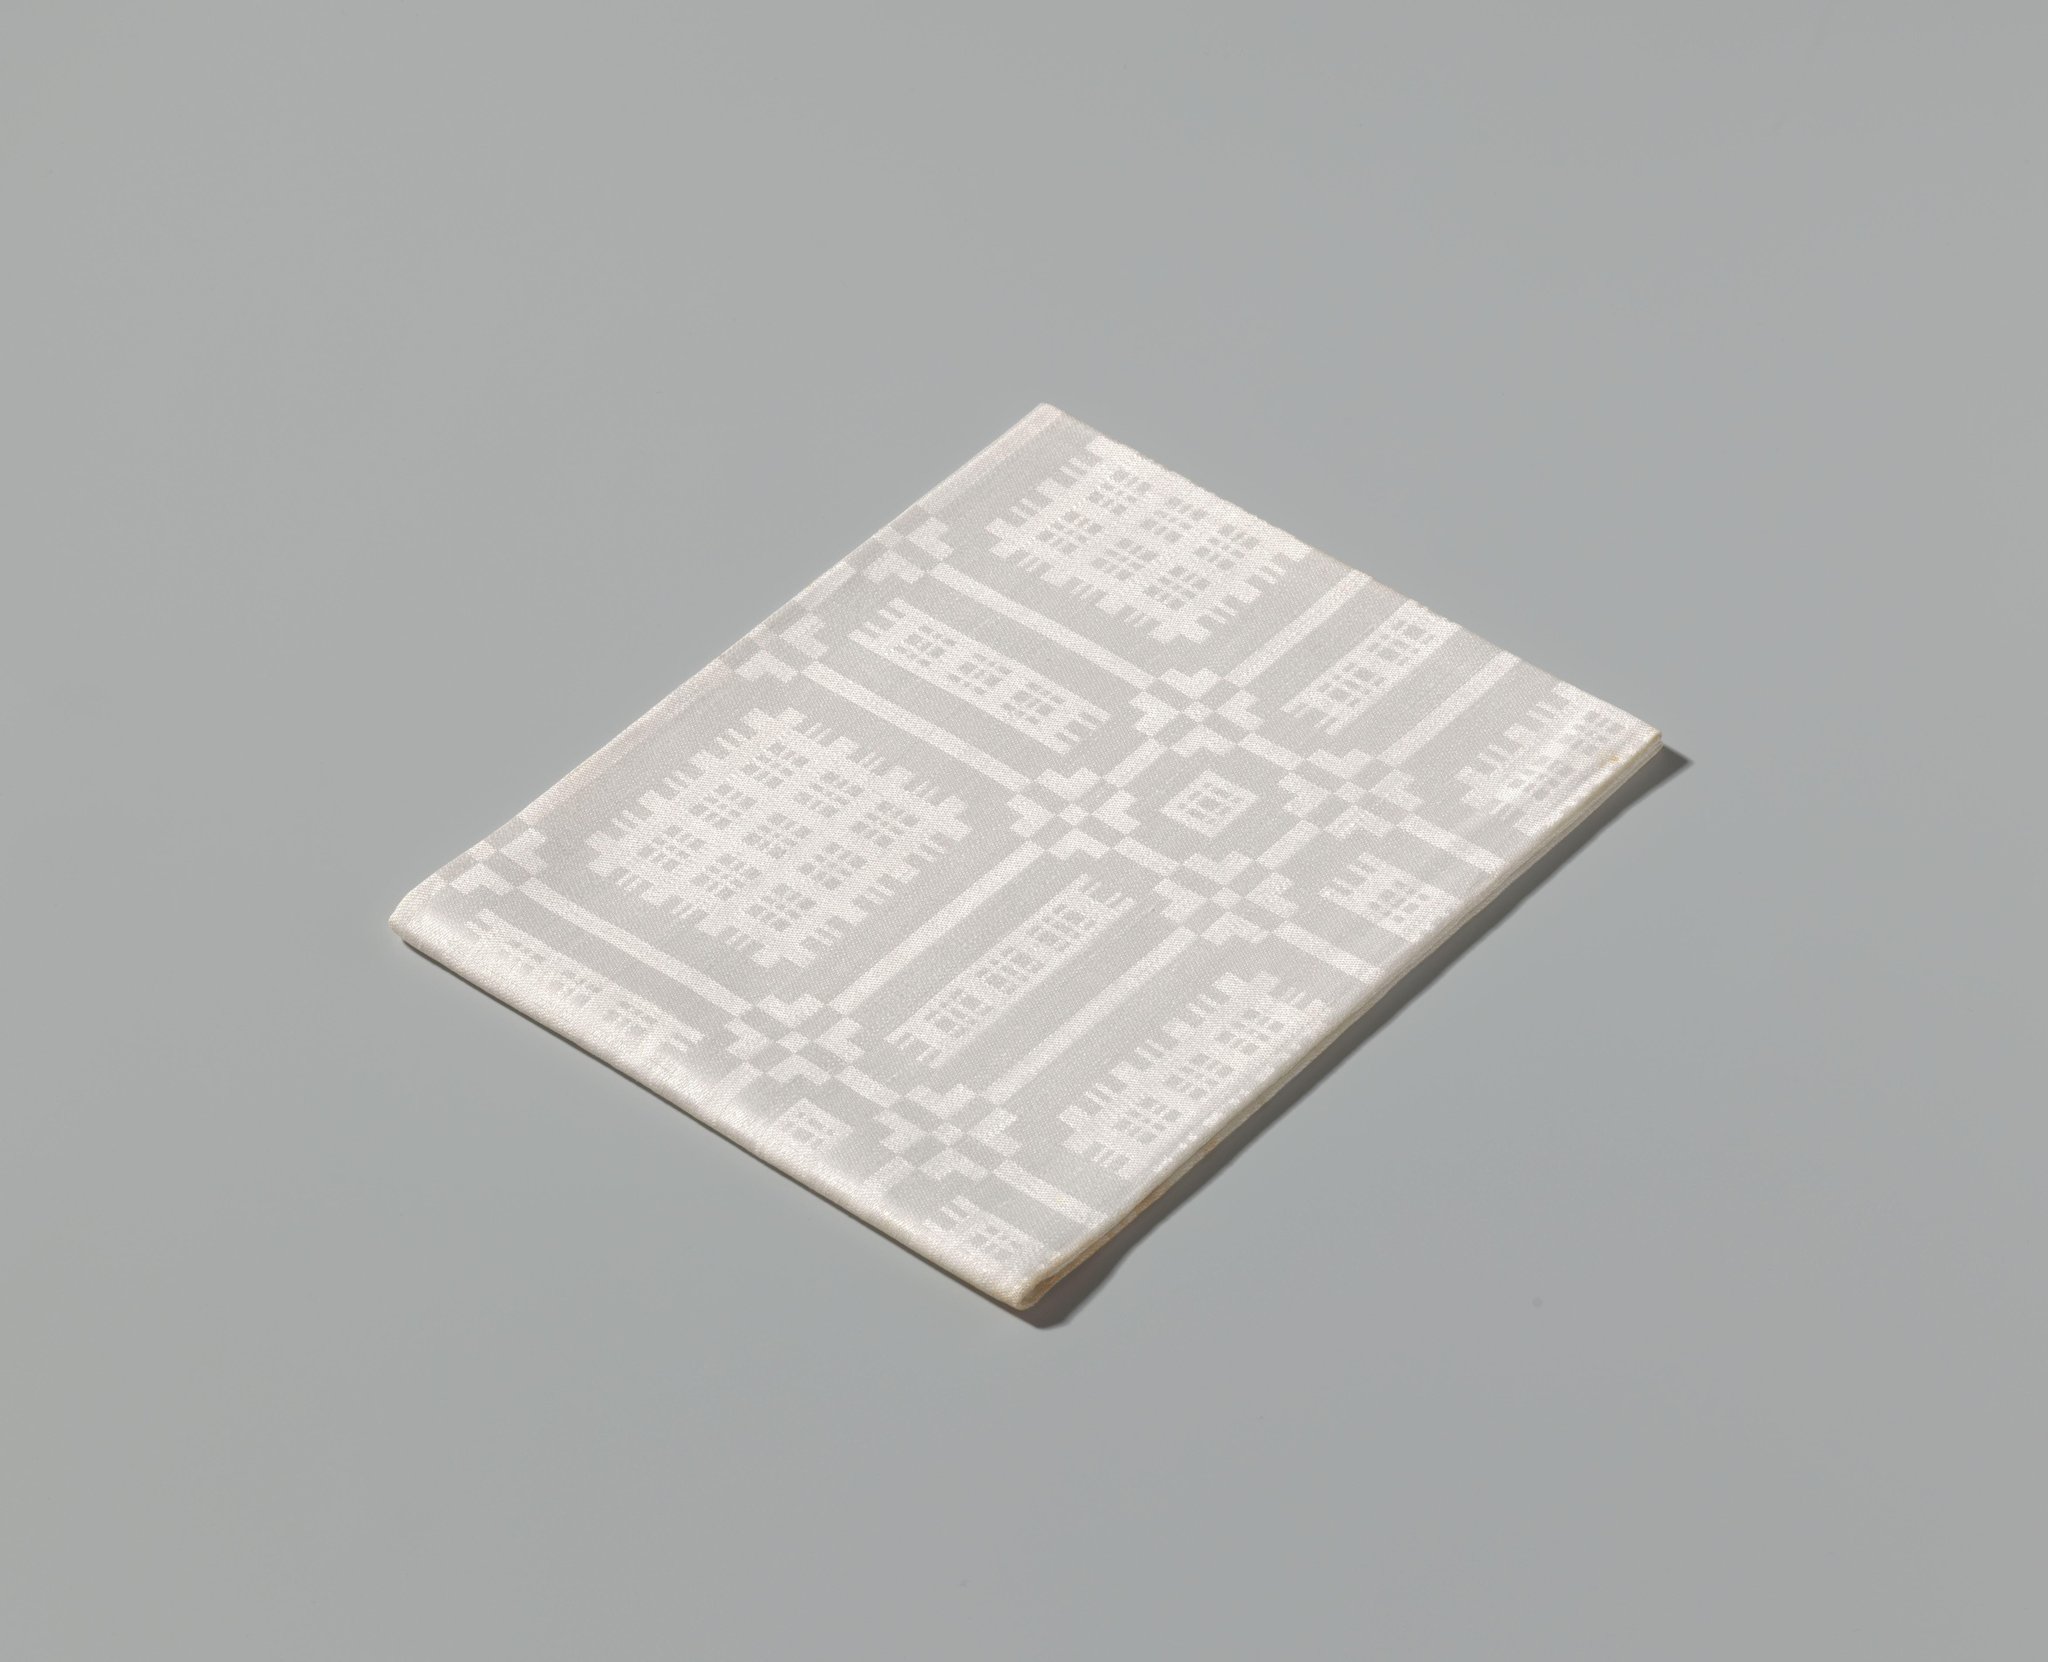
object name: napkin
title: Servet van linnen met pellenpatroon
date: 1700-1799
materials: linen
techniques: peeled fabric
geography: netherlands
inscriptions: : ‘WH 2oonl’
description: Wit linnen servet met een pellenpatroon.